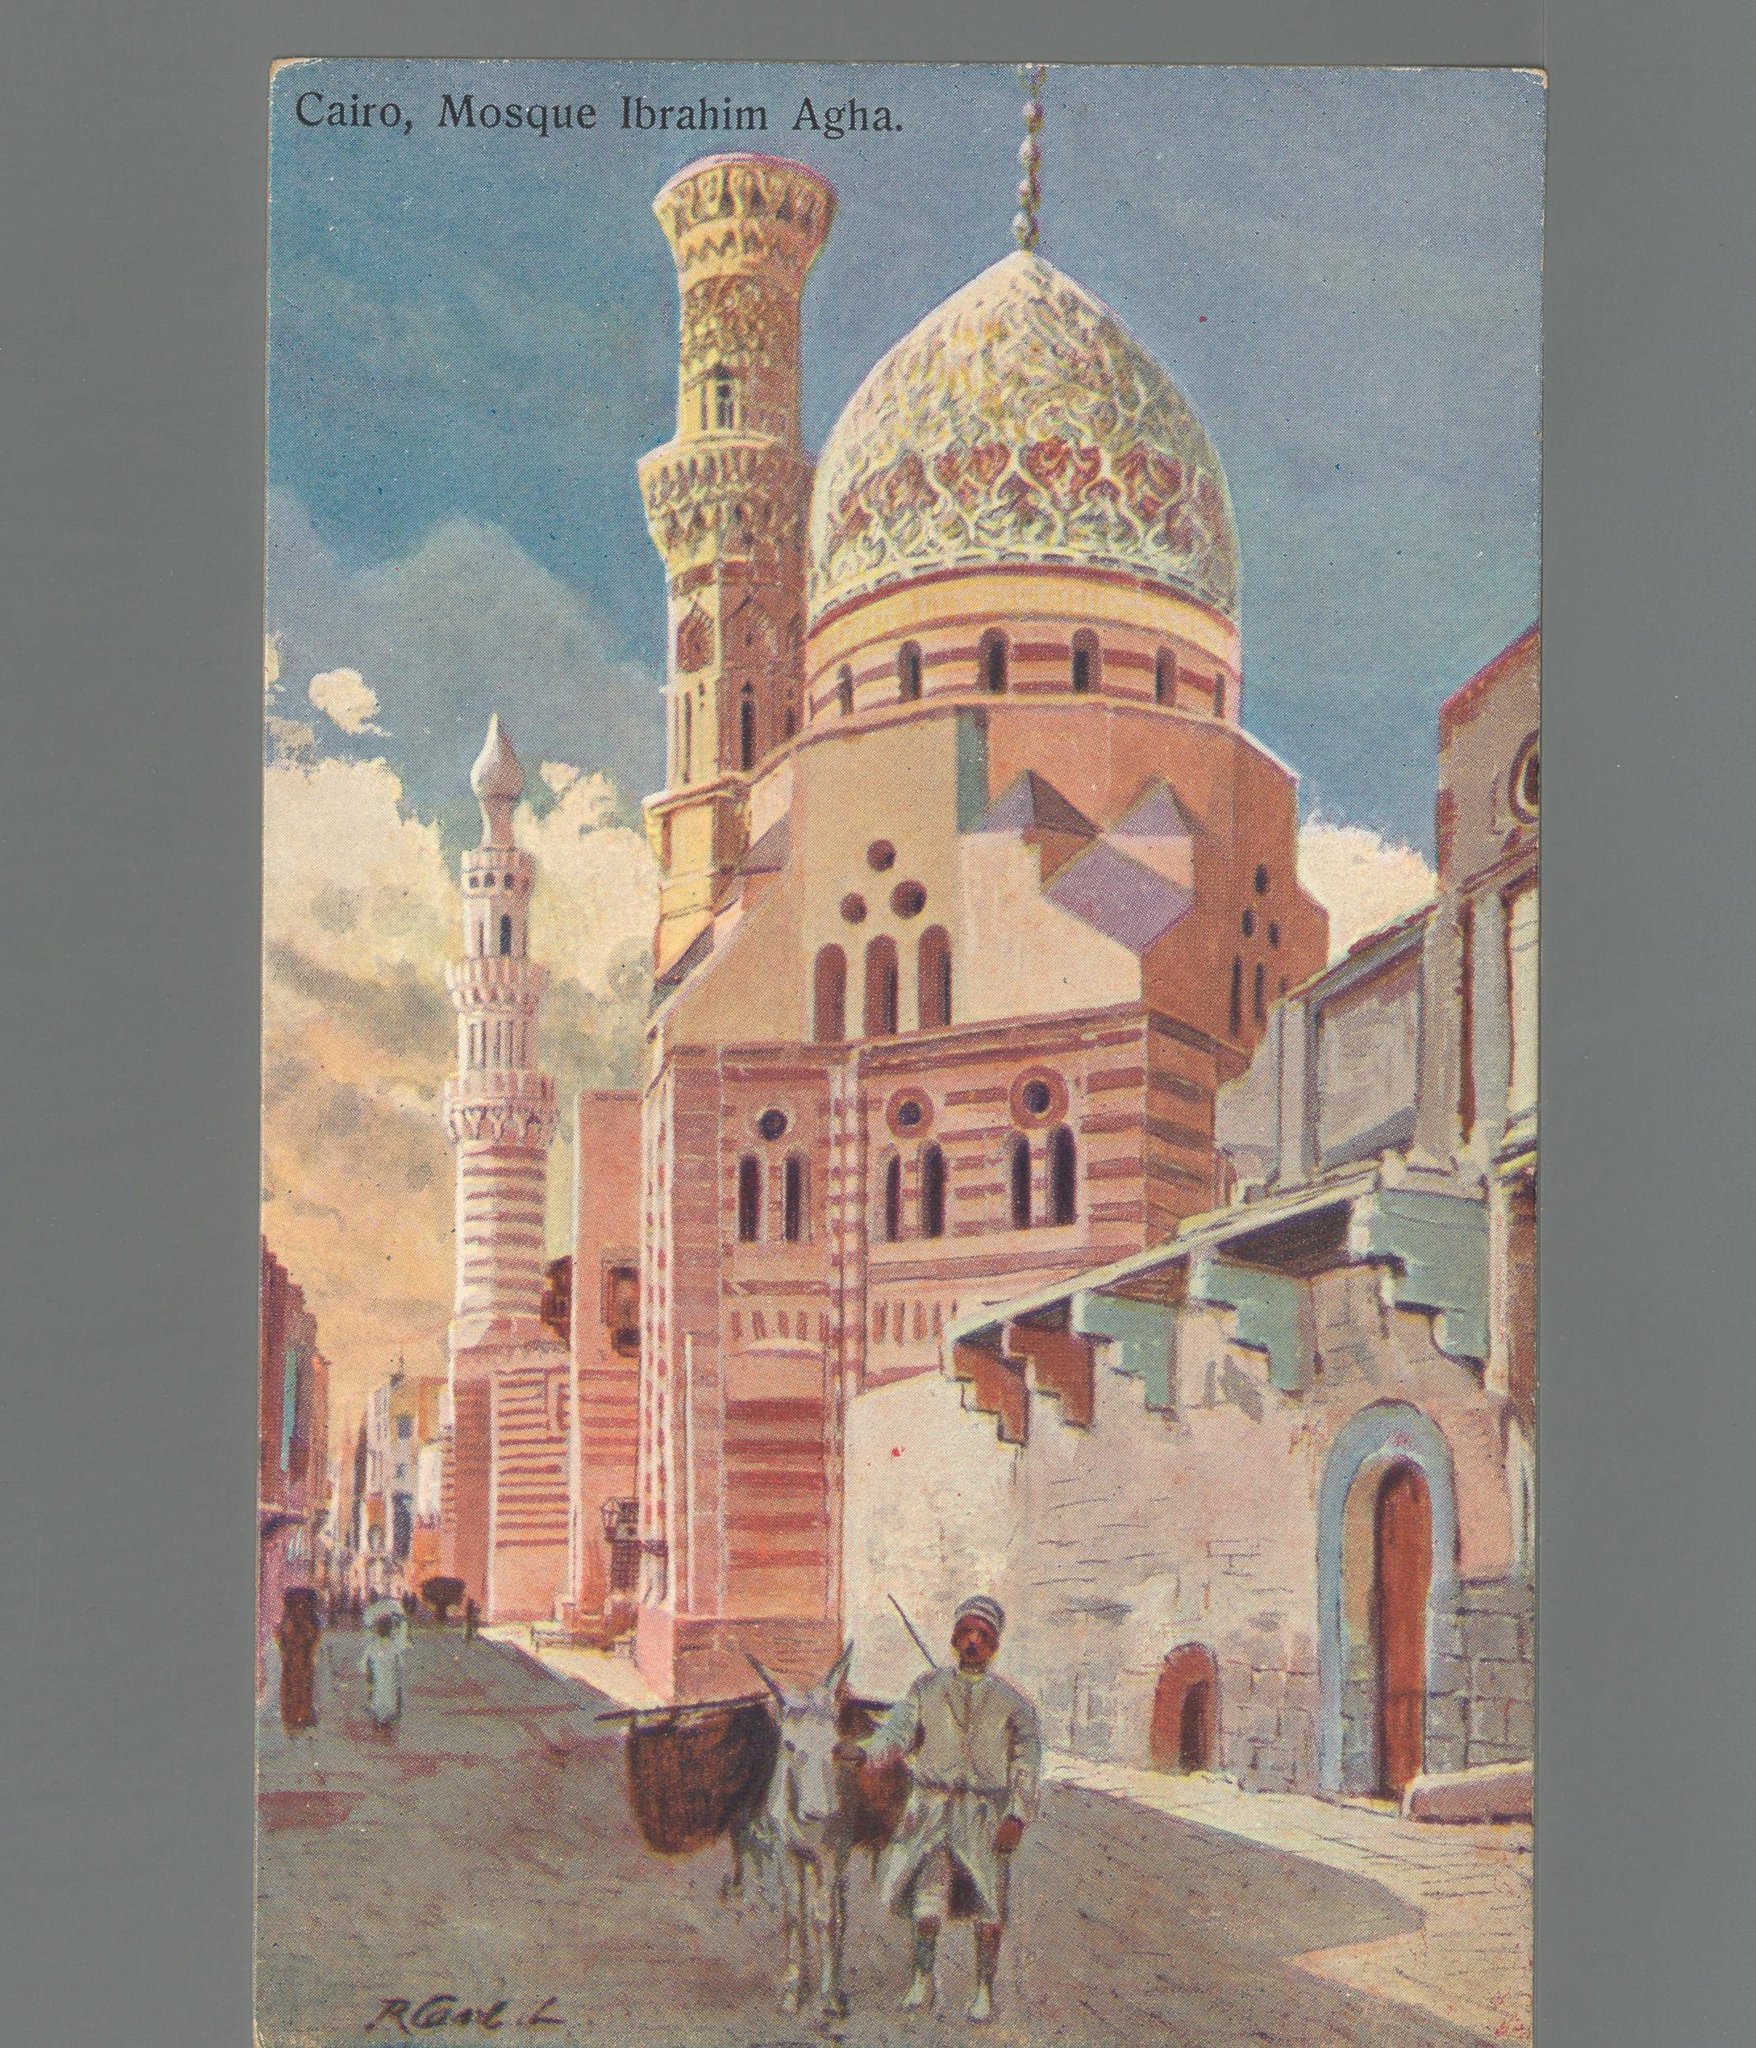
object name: ansichtkaart, prentbriefkaart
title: Cairo, Mosque Ibrahim Agha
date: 1907-1930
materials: cardboard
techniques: color autotype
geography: cairo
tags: quadrangular pyramid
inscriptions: inscription: ‘R. Carl L.’